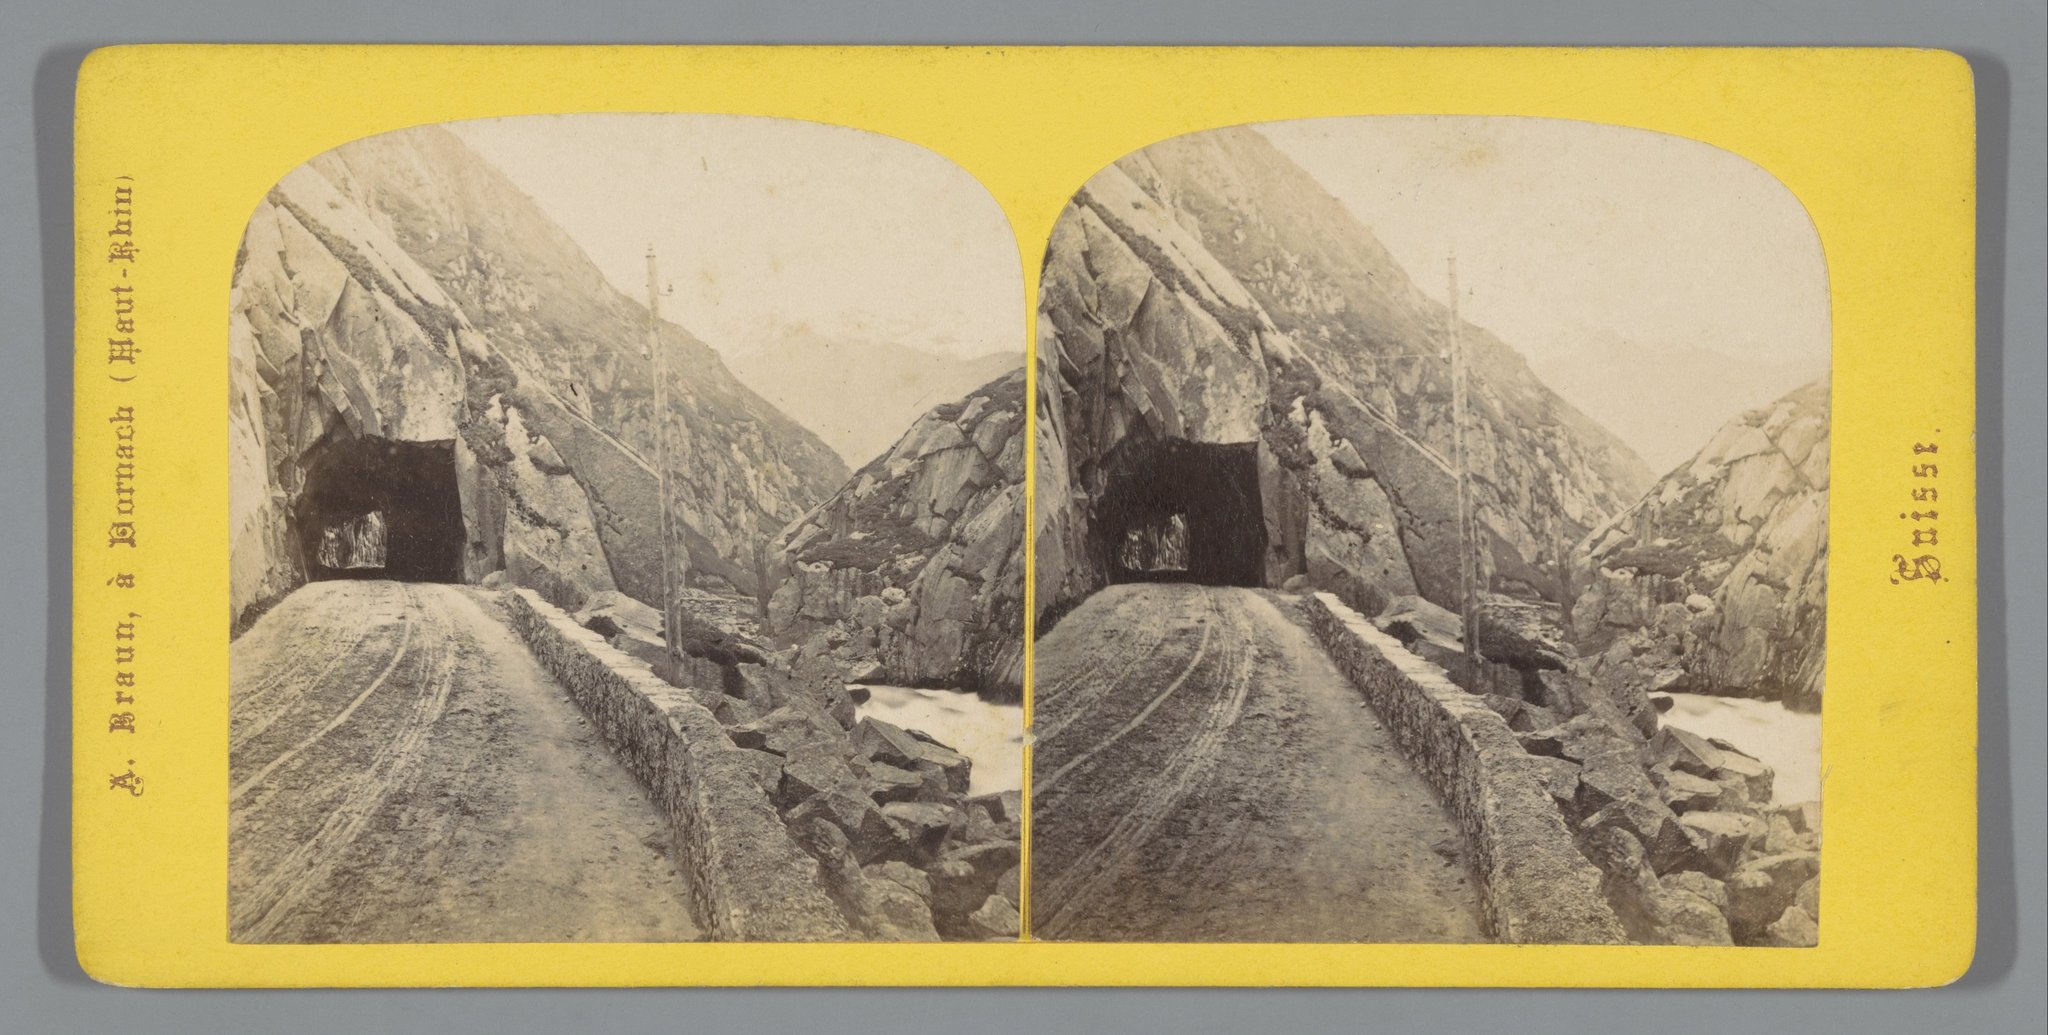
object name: stereograph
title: Route du St. Gothard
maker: Anonymous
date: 1879-1889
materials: cardboard, paper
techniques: albumen print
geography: dornach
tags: road, path, underground road, tunnel, mountains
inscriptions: number: ‘6941 [?]’